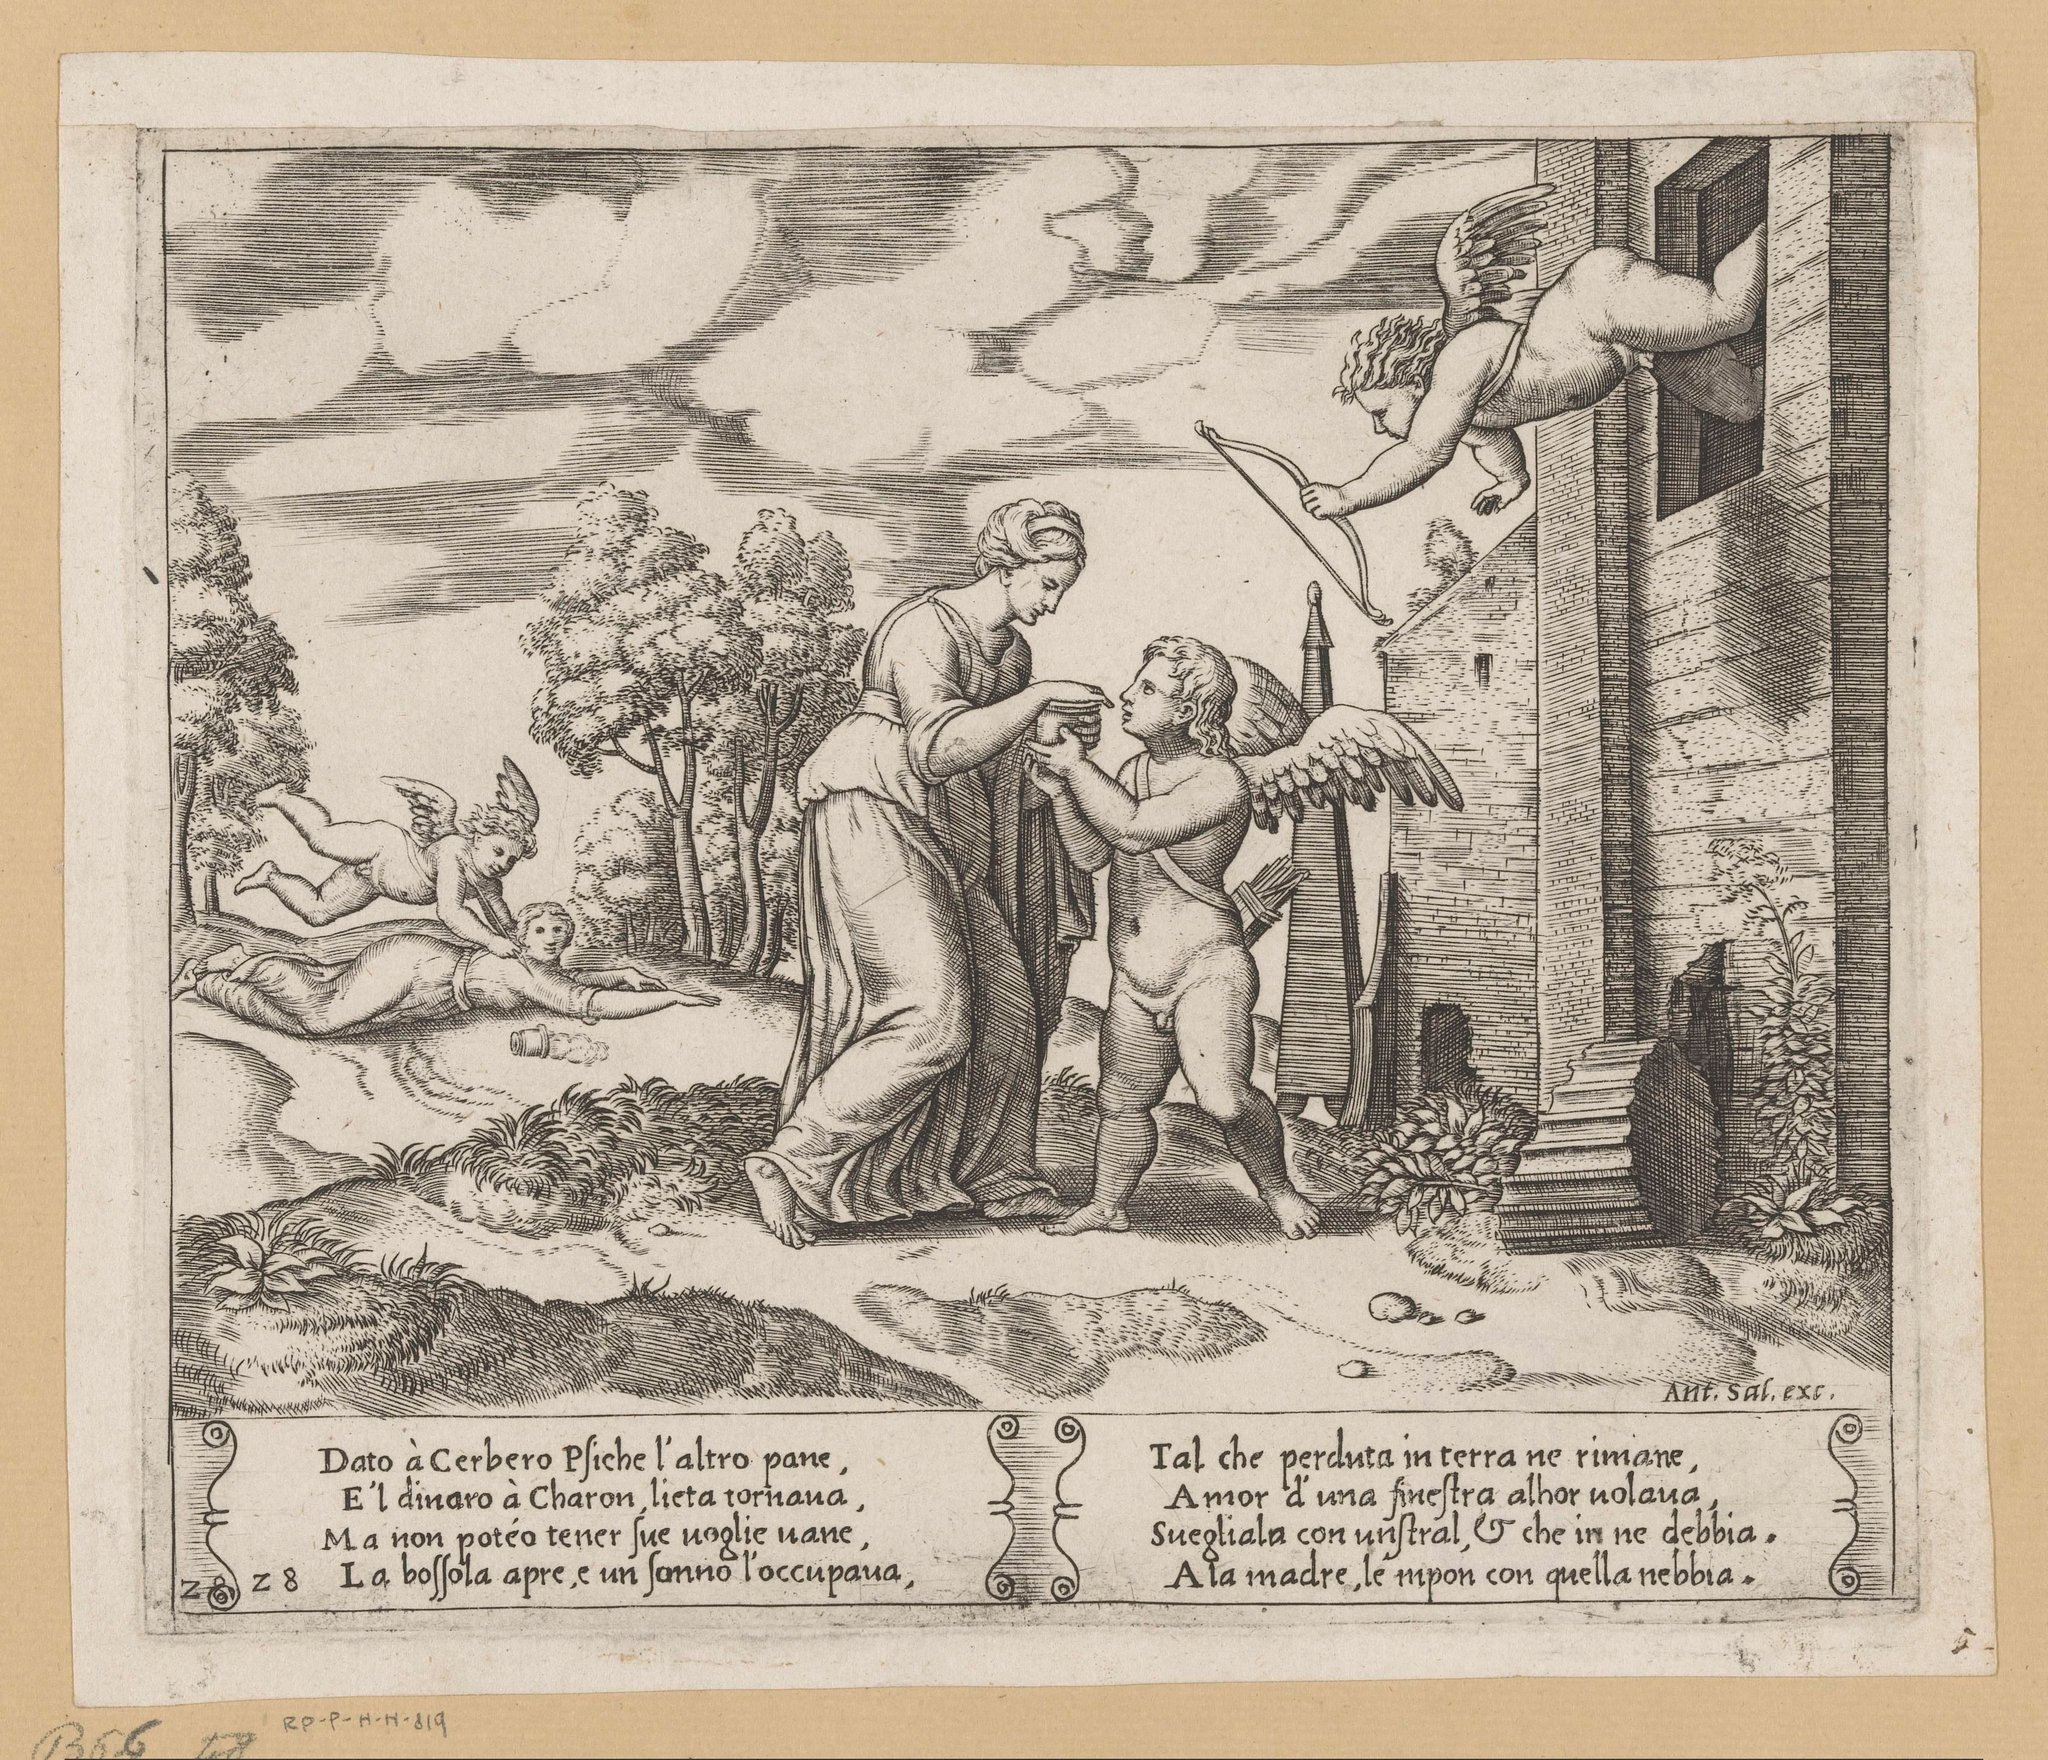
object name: print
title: Verhaal van Amor en Psyche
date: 1530-1560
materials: paper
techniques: engraving, intaglio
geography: italy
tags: cupid awakes psyche from her deadly sleep, psyche, on her way back, opens proserpina's casket and is overcome by sleep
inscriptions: collector's mark: Lugt 11, collector's mark: Lugt 10, number: ‘5’, collector's mark: ‘Hinloopen’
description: Verleid door het idee dat het haar mooier zal maken, opent Psyche de kruik gevuld met schoonheid van Proserpina, de godin van de onderwereld. Rechts ontsnapt Amor uit het raam van het paleis waarin Venus hem opsloot. Links ontwaakt de neergevallen Psyche waarna Amor haar zal meenemen. Italiaanse tekst in twee cartouches in ondermarge. Tweemaal genummerd linksonder: 28.